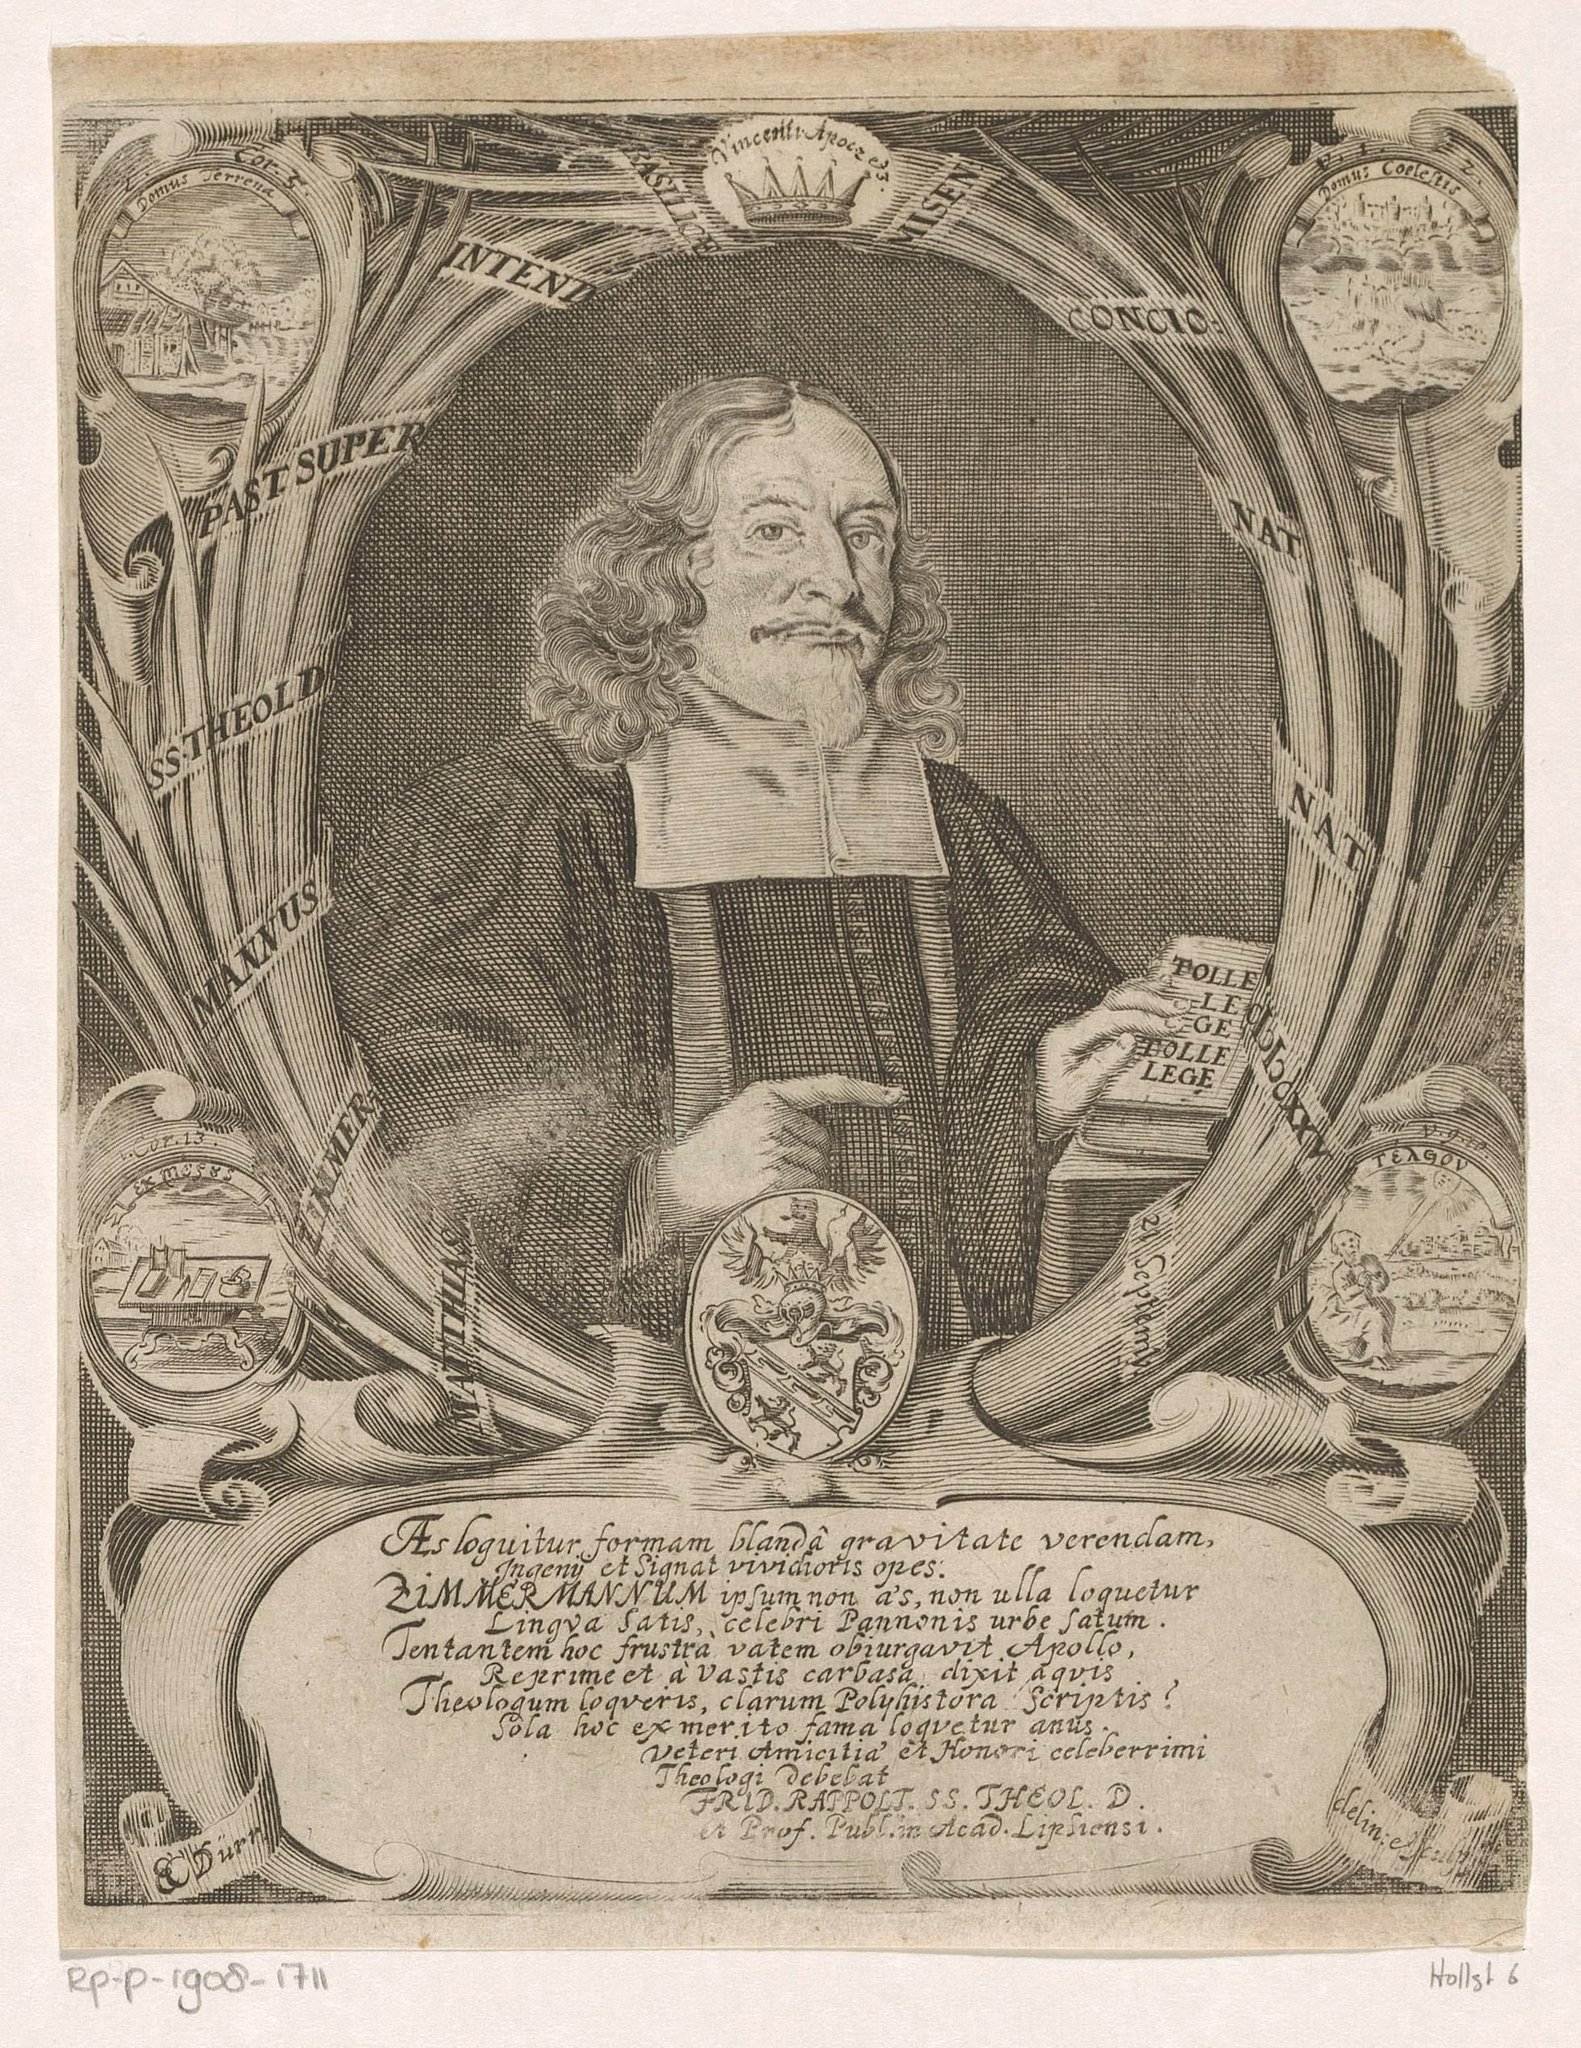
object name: print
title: Portret van Johann Marcus Goebel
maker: georg kilian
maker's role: print maker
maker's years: 1683-1745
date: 1710-1745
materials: paper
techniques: mezzotint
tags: trees: palm-tree (+ branch, stick), historical persons, book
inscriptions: collector's mark: Lugt 2228